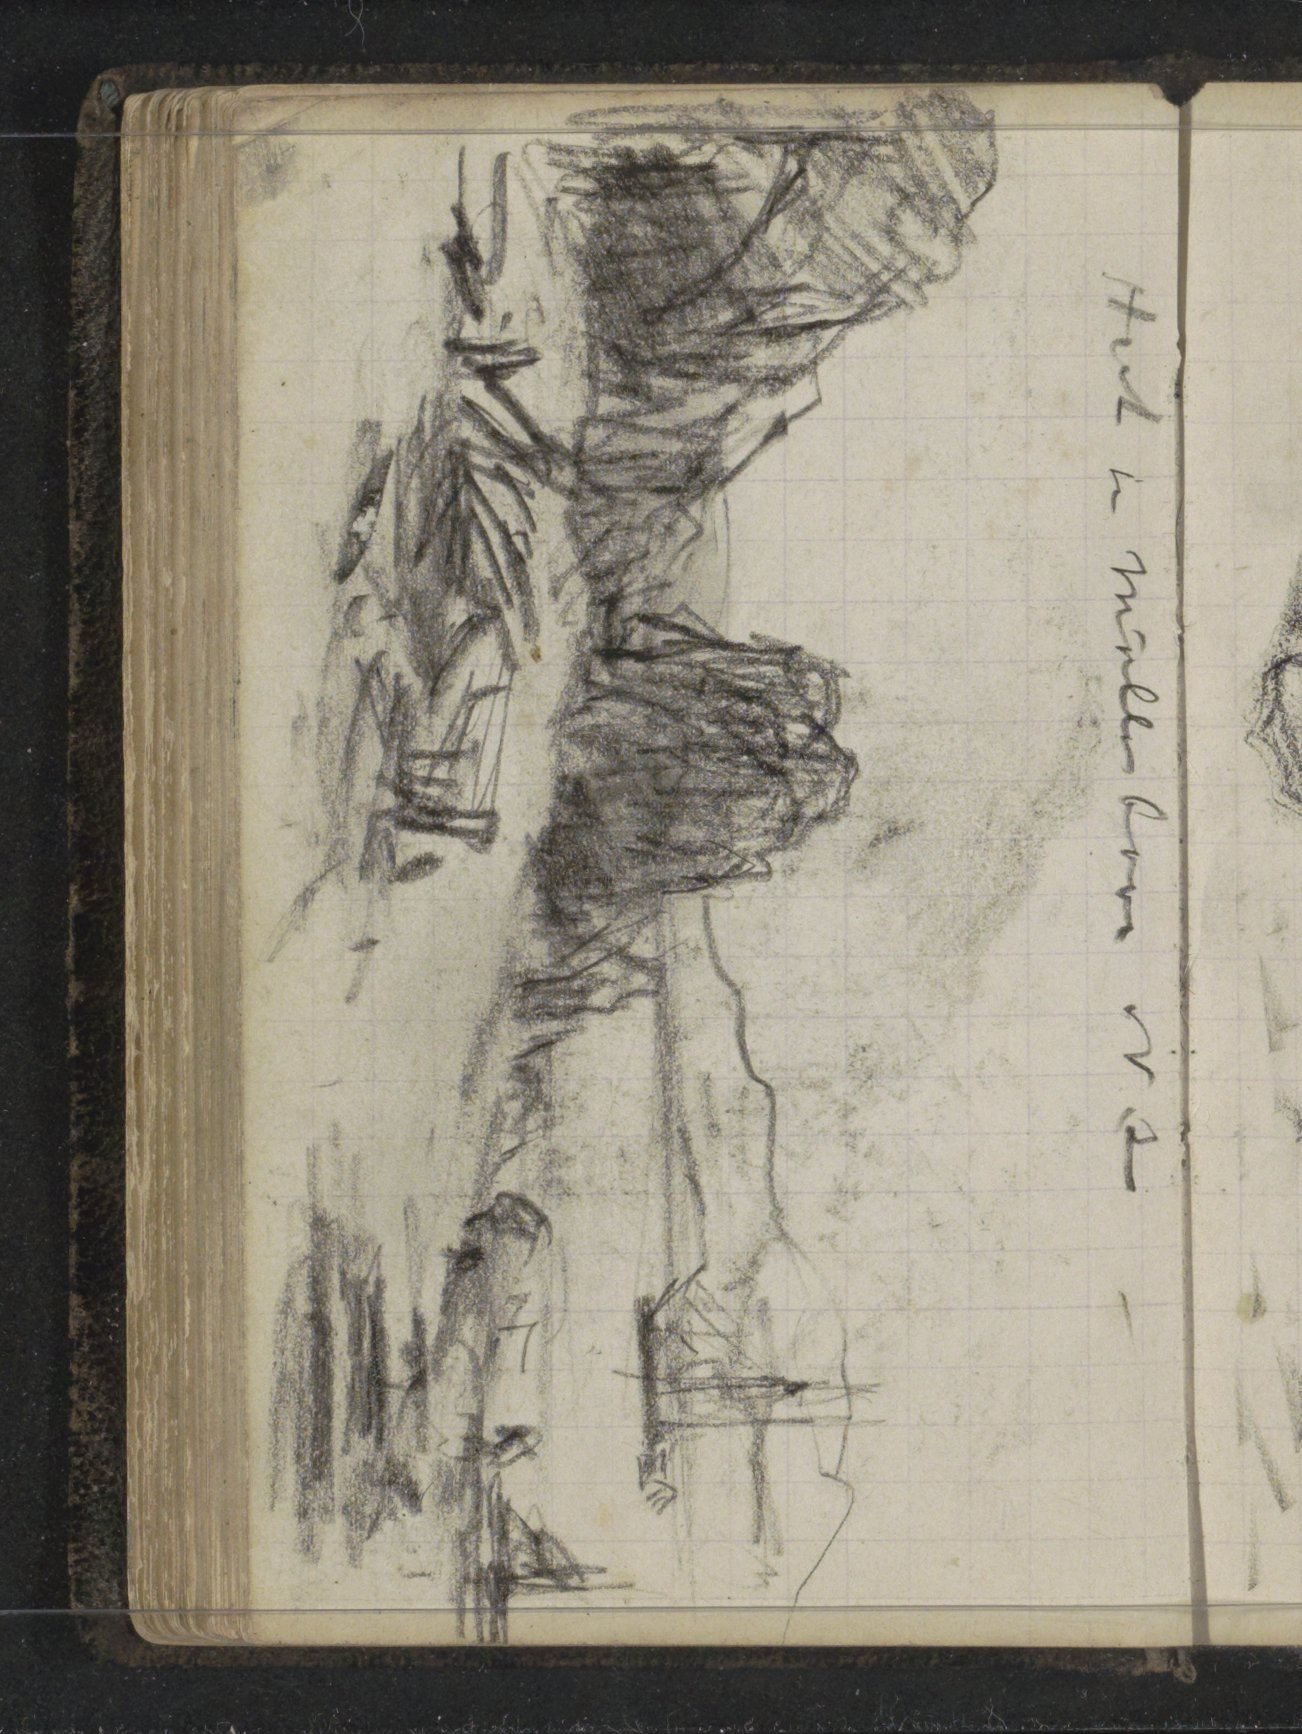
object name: sketchbook leaf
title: Hut in de Willemsbaai te Nova Zembla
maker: louis apol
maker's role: draughtsman, painter, print maker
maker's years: 1850-1936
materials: chalk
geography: novaya zemlya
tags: gulf, bay, sailing-ship, sailing-boat, hut, cabin, lodge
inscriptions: annotation: ‘Hut in Willemsbaai N Z’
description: Voor de kust ligt de schoener Willem Barentsz. Vooraan wrakhout. Blad 55 verso uit een schetsboek met 110 bladen betekend tijdens de expeditie naar Nova Zembla in 1880.